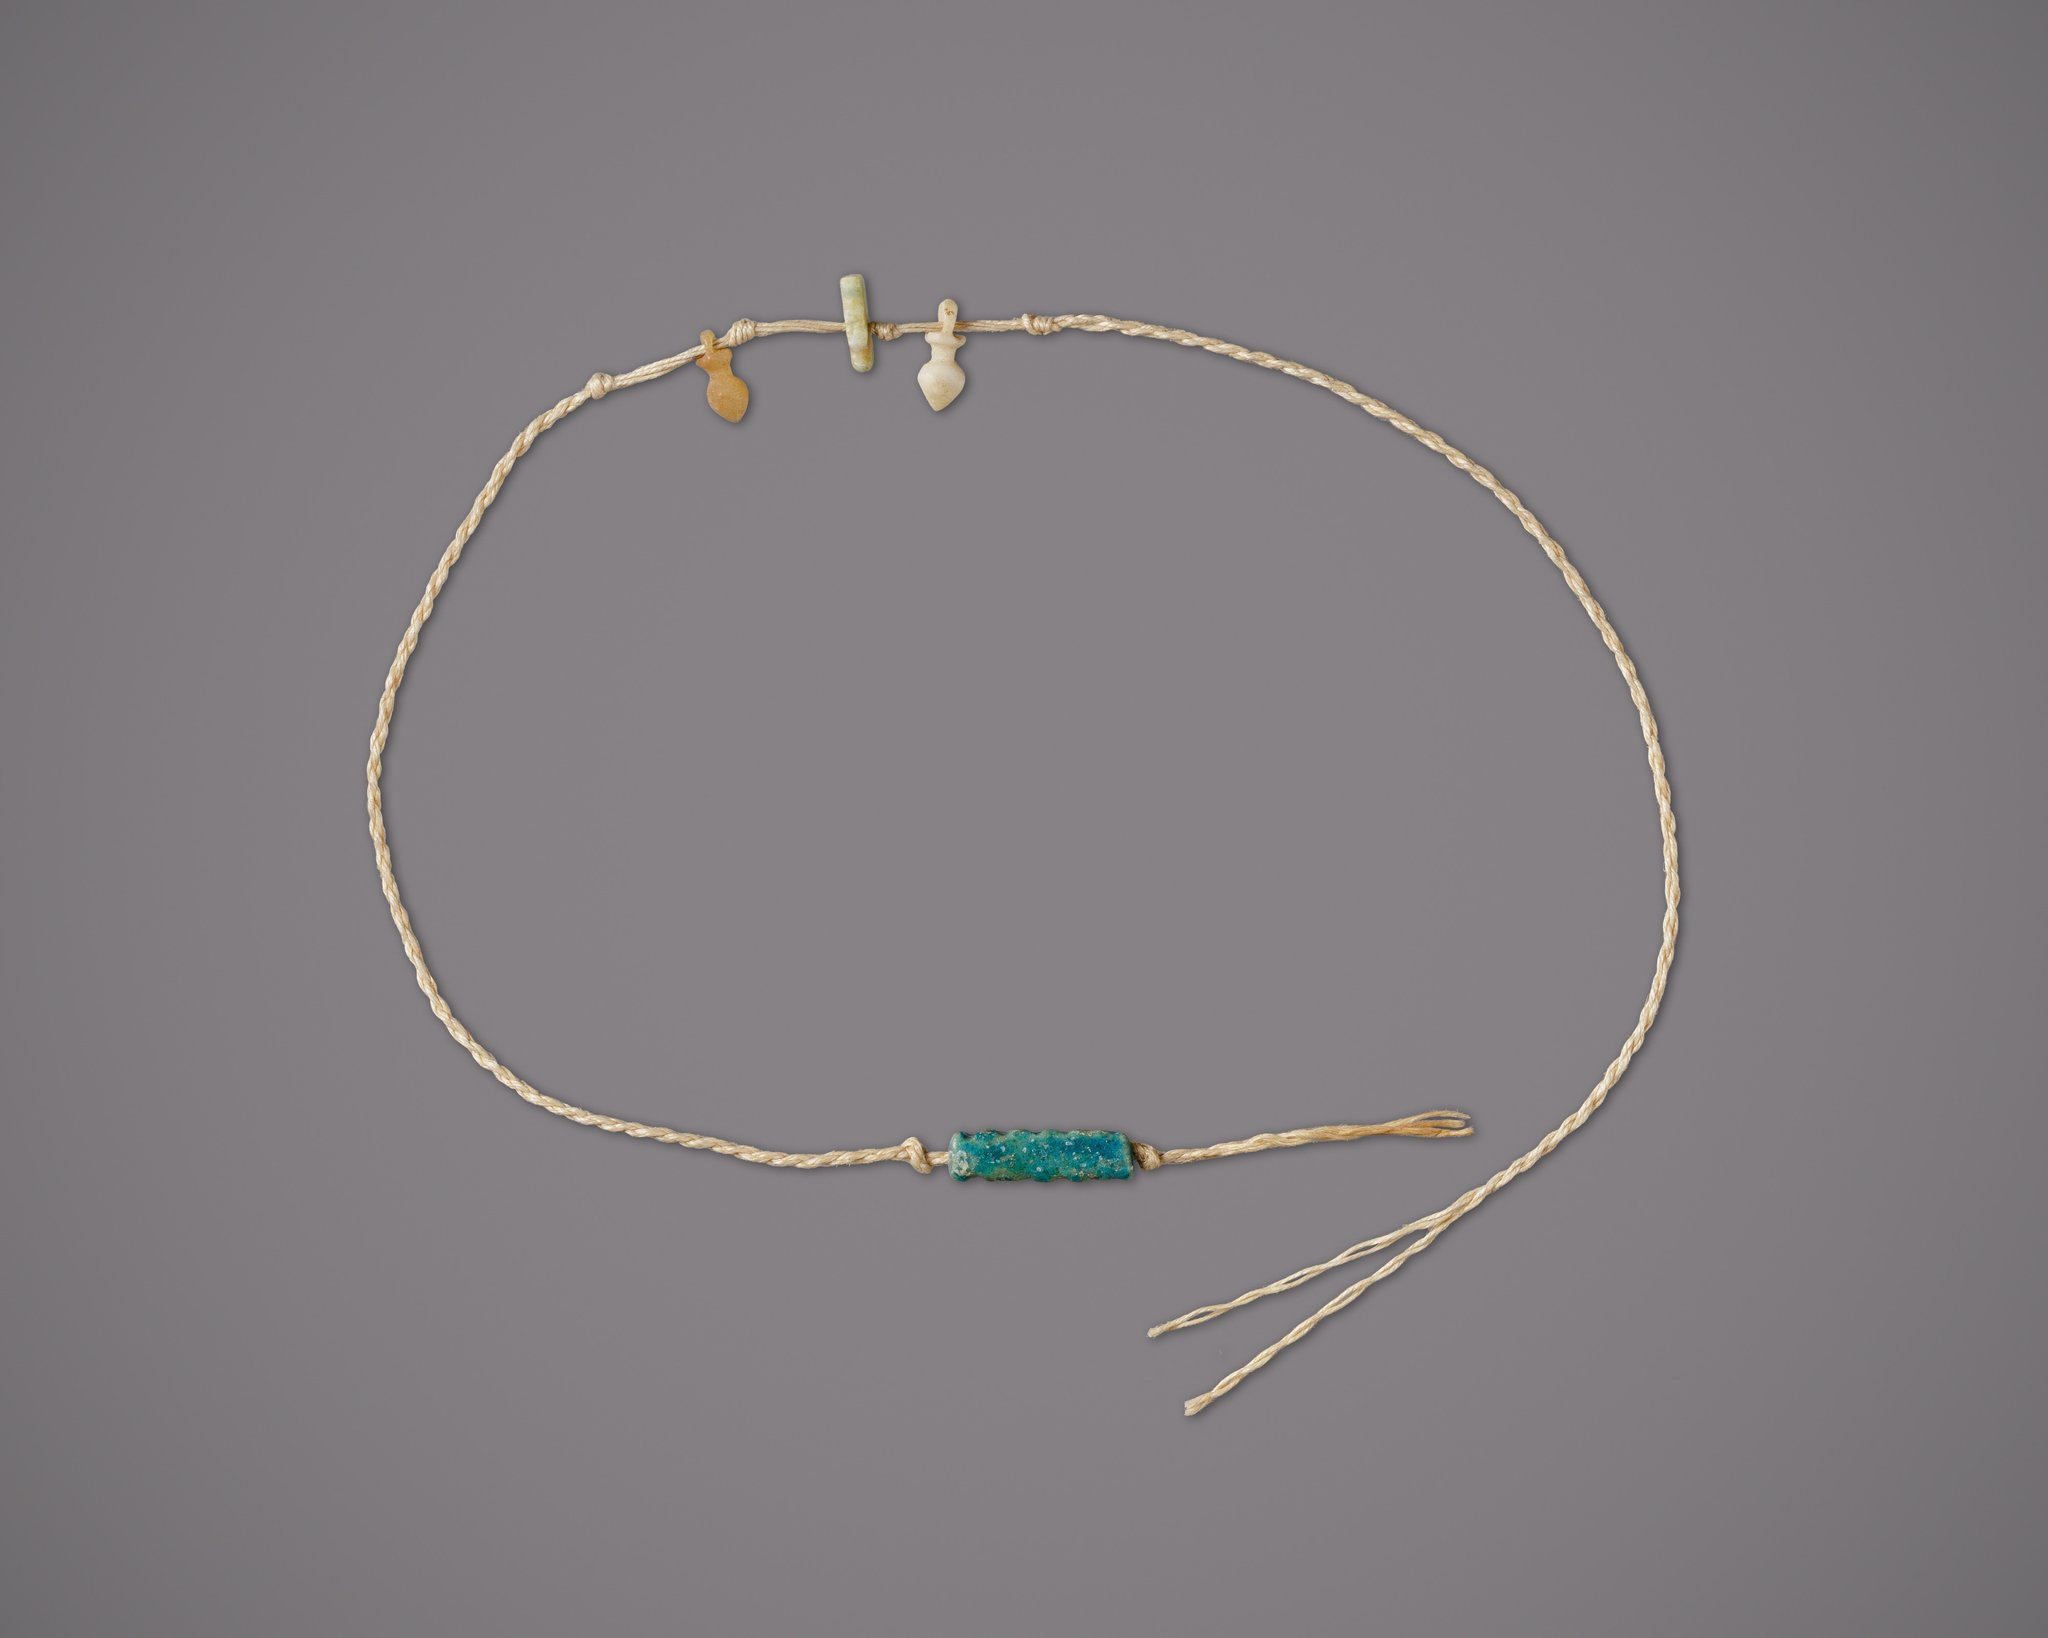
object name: amulet string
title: String of amulets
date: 1580-1479 BCE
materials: alabaster, faience, linen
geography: egypt